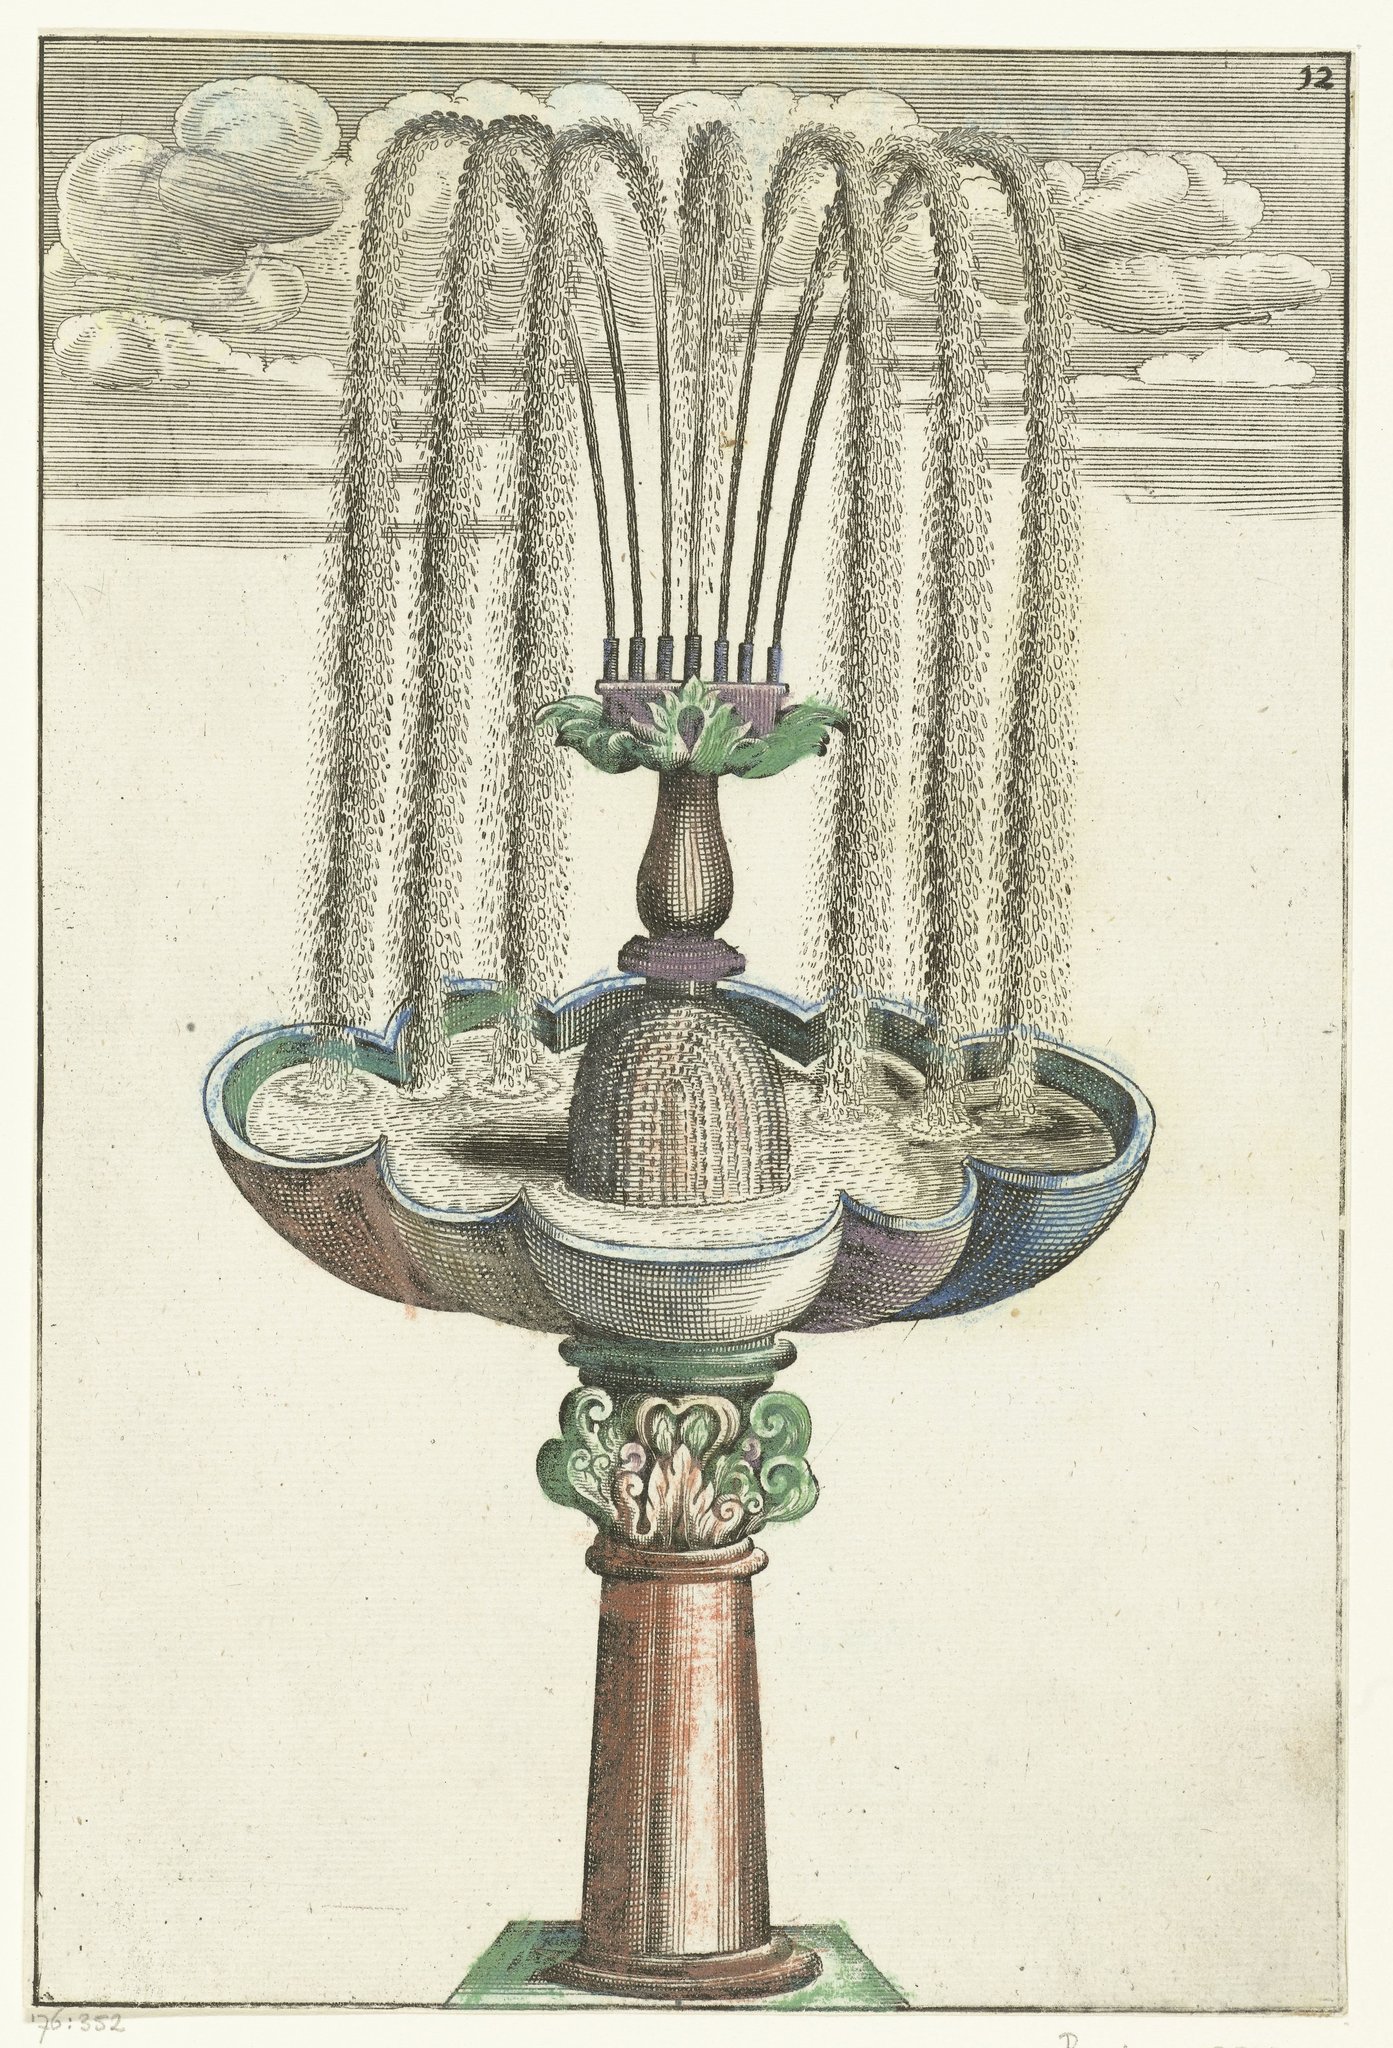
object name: ornament print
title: Architectura Curiosa Nova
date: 1664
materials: paper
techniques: etching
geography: nuremberg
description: Het bassin staat op een korte zuil met een denkbeeldig kapiteel. Uit het bassin rijst een gestileerde vaasvorm die eindigt in zeven tuiten. Blad 12 uit deel III van een serie bestaande uit 226 bladen, verdeeld over vier boeken, elk met een eigen titelblad.